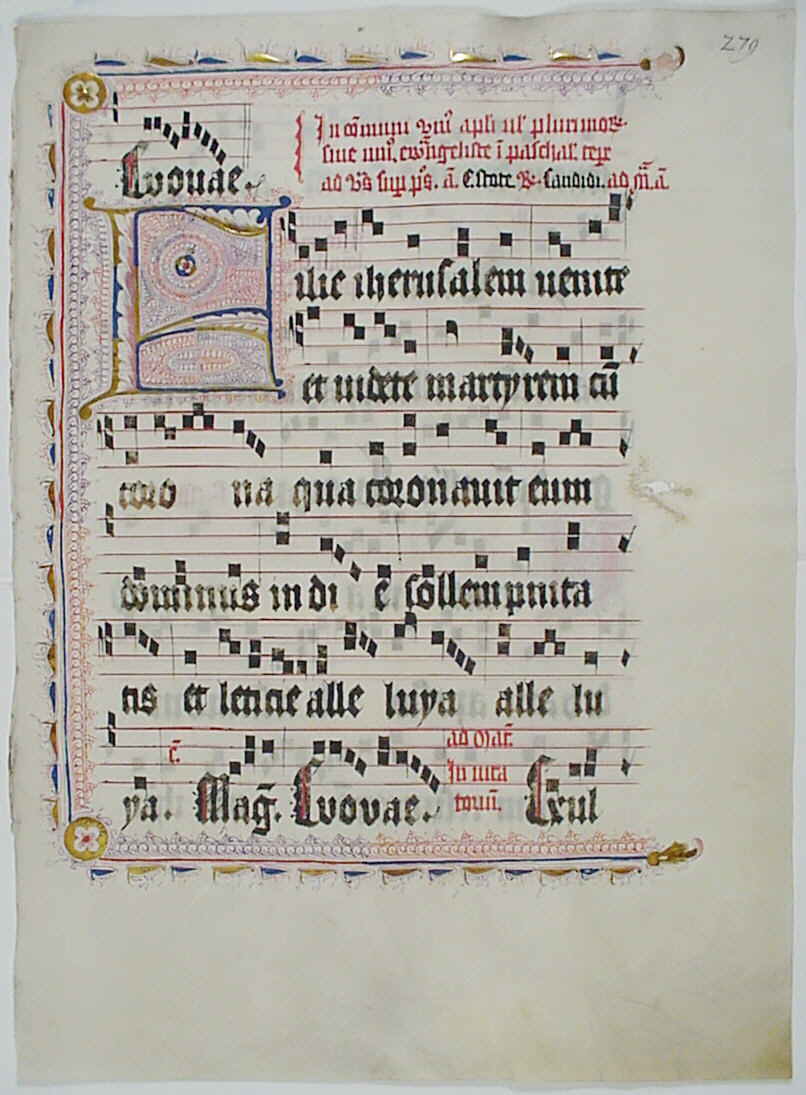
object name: antiphonary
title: Manuscript Leaf with Initial F, from an Antiphonary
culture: german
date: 1426-1450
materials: ink, metal leaf, parchment, paint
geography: germany